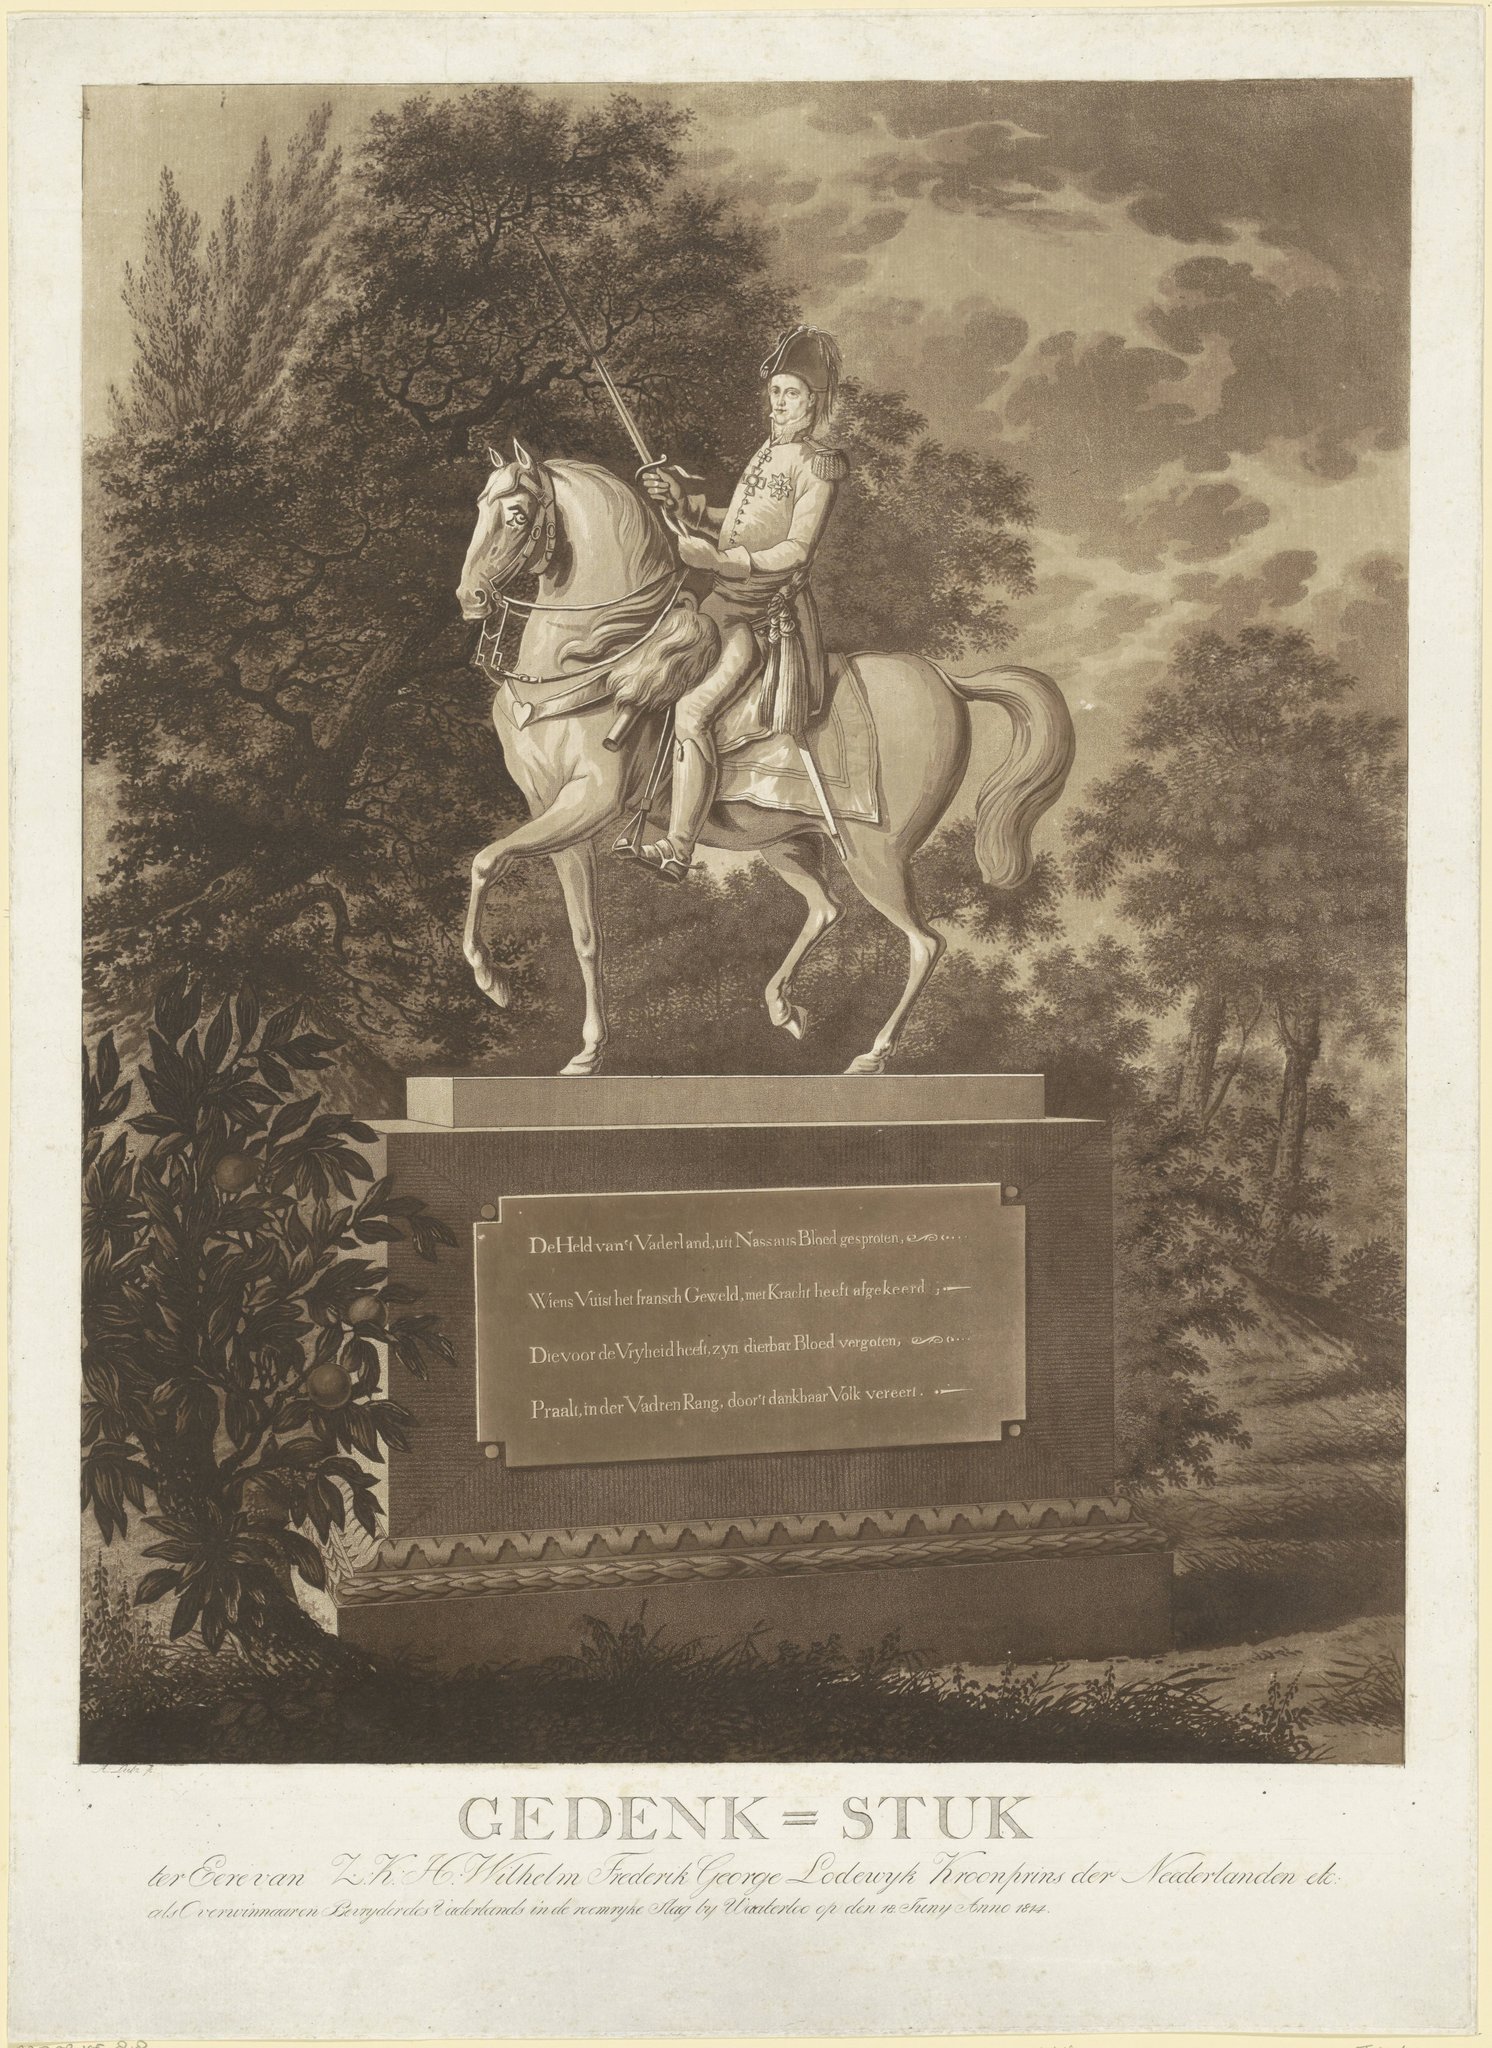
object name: print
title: Ruiterstandbeeld van Willem II, koning der Nederlanden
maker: a. lutz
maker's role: print maker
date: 1815-1822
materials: paper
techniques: aquatint, etching, hand coloring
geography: the hague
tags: the hague, william ii of the netherlands, equestrian statue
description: De hier vermelde titel verwijst naar de hoogst verkregen titel van de geportretteerde, niet per se naar de titel die de geportretteerde op deze voorstelling draagt.